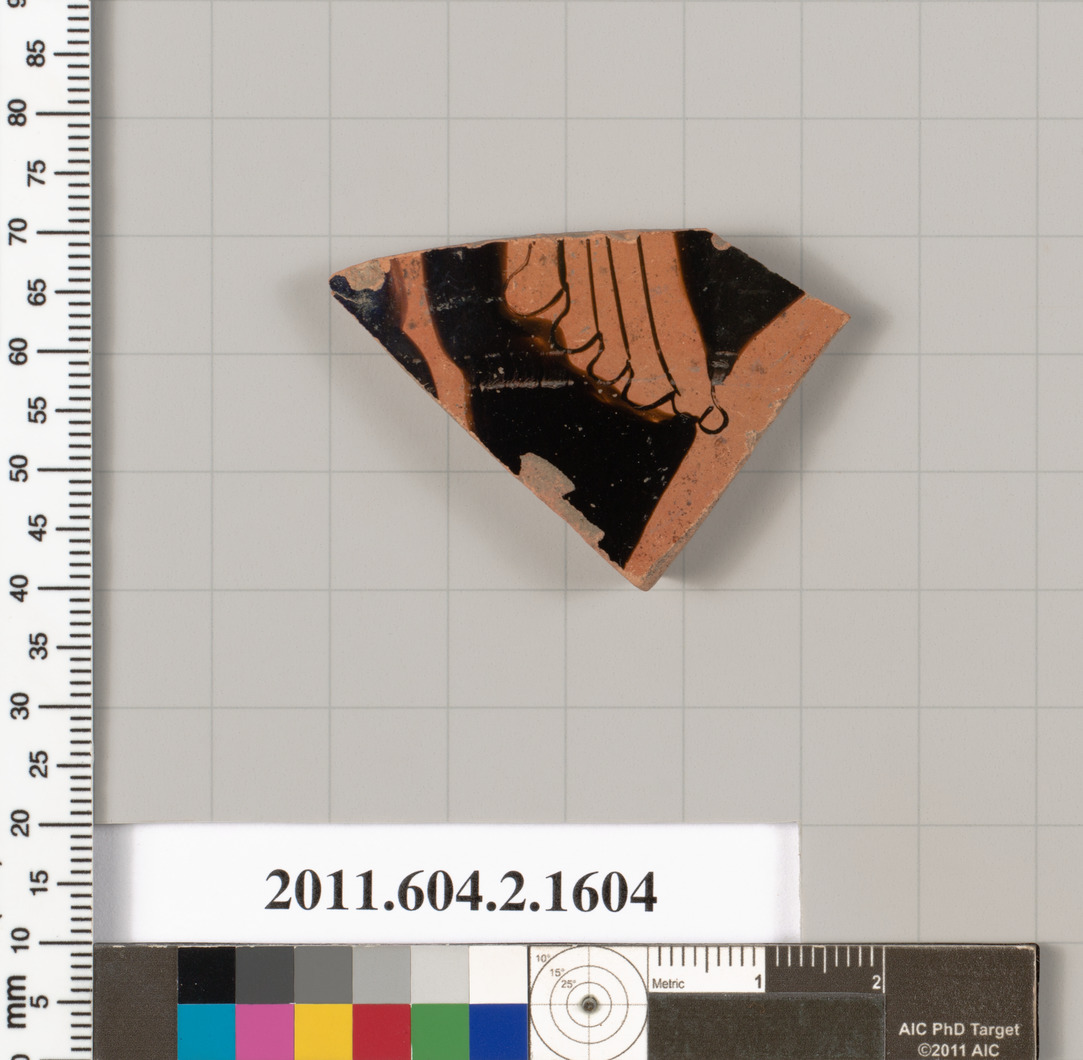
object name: skyphos fragment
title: Terracotta fragment of a skyphos (deep drinking cup)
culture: greek, attic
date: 490-470 BCE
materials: terracotta